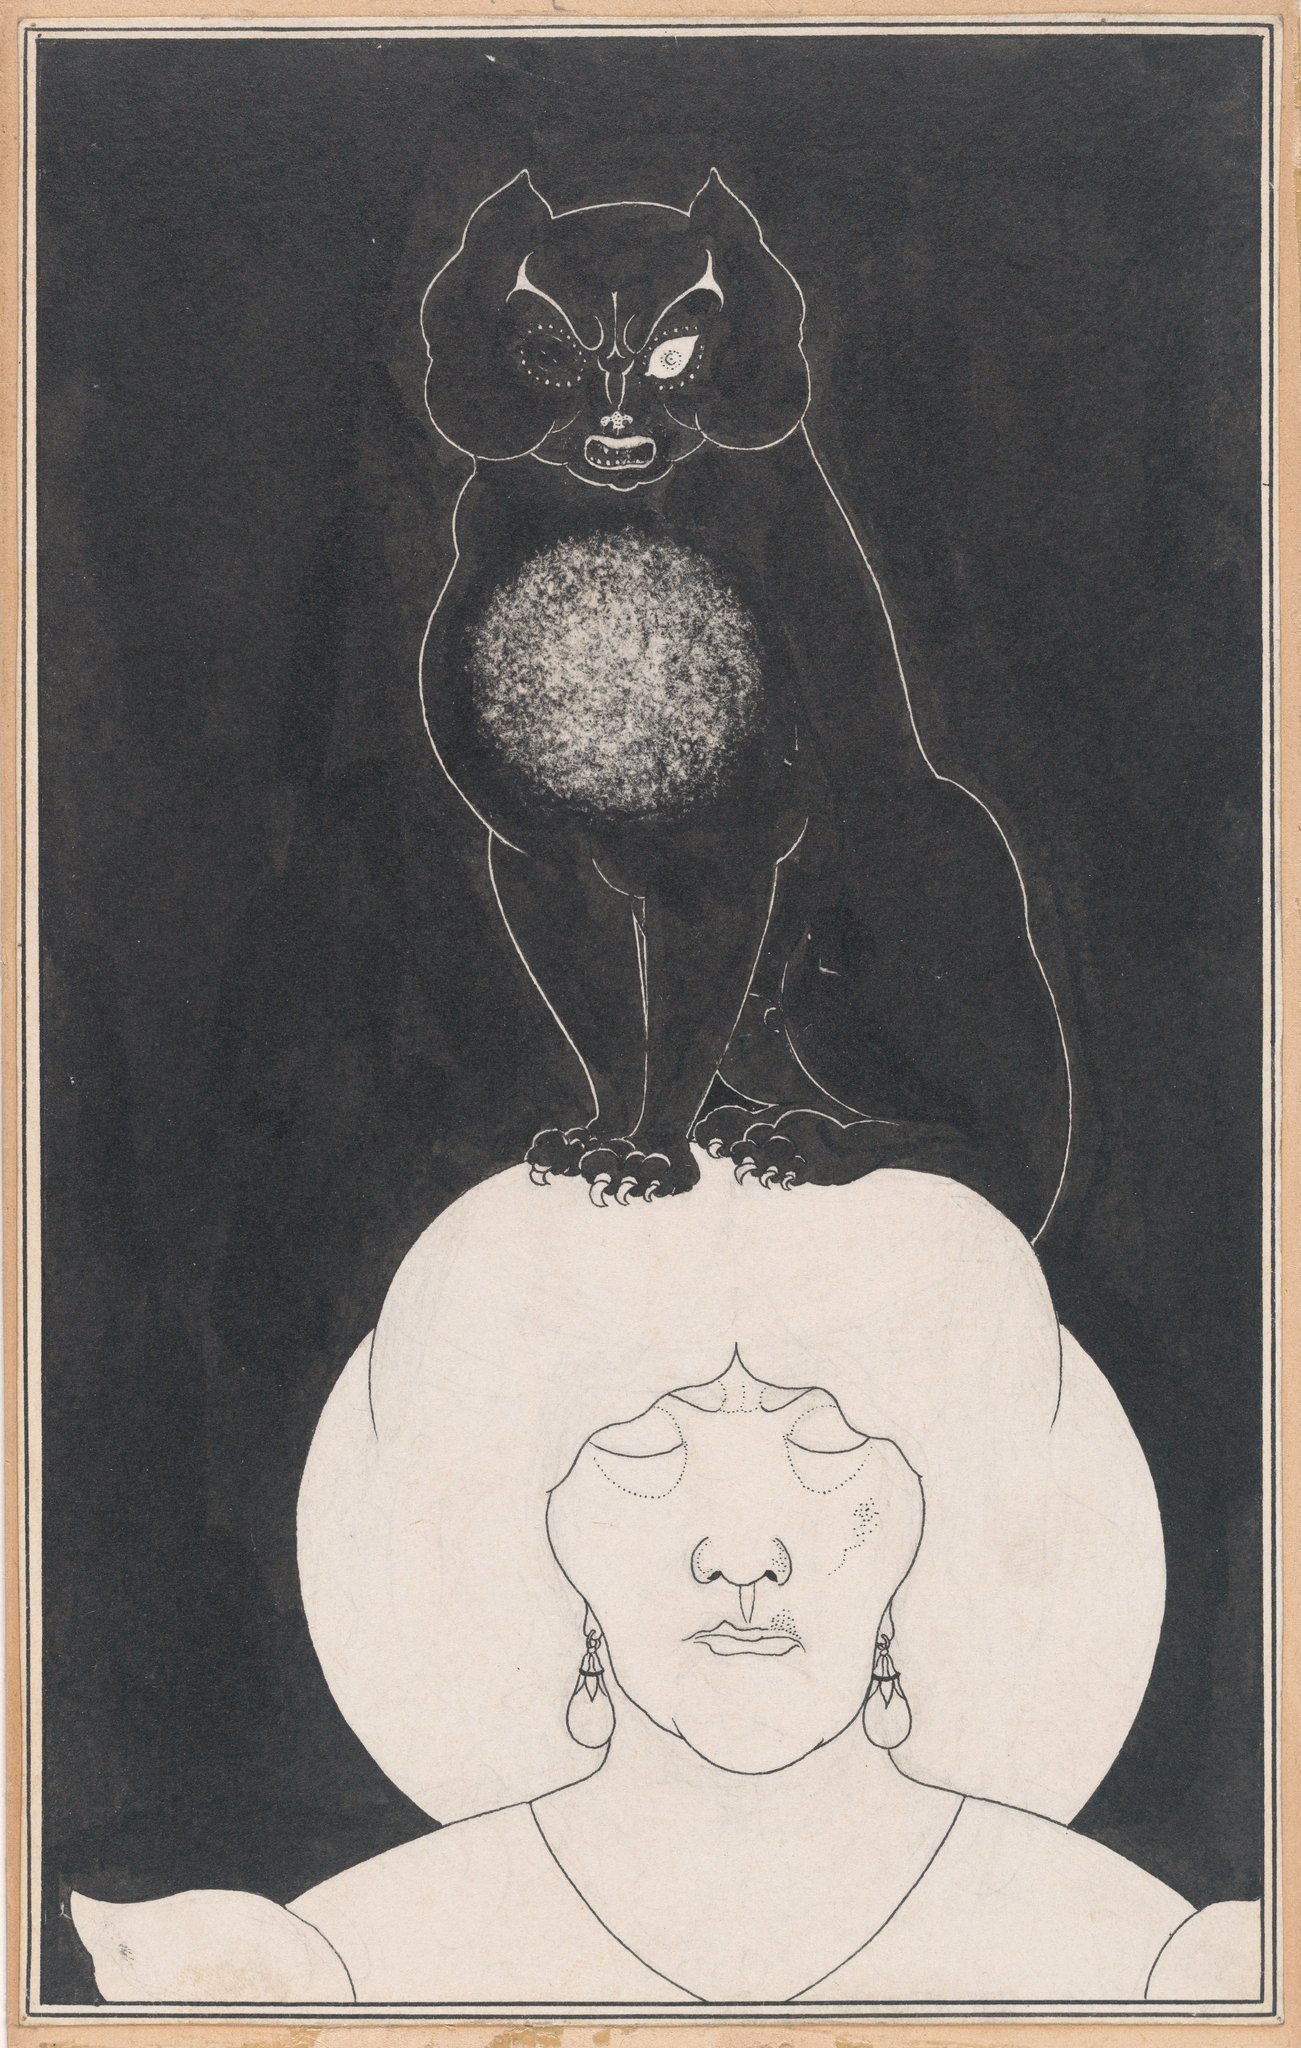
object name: drawing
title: The Black Cat, for Edgar Allan Poe’s “Tales of Mystery and the Imagination,” Chicago, 1895–96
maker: aubrey vincent beardsley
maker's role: artist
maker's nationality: british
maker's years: 1872-1898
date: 1894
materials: graphite, ink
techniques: brush, pen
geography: great britain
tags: women,cats